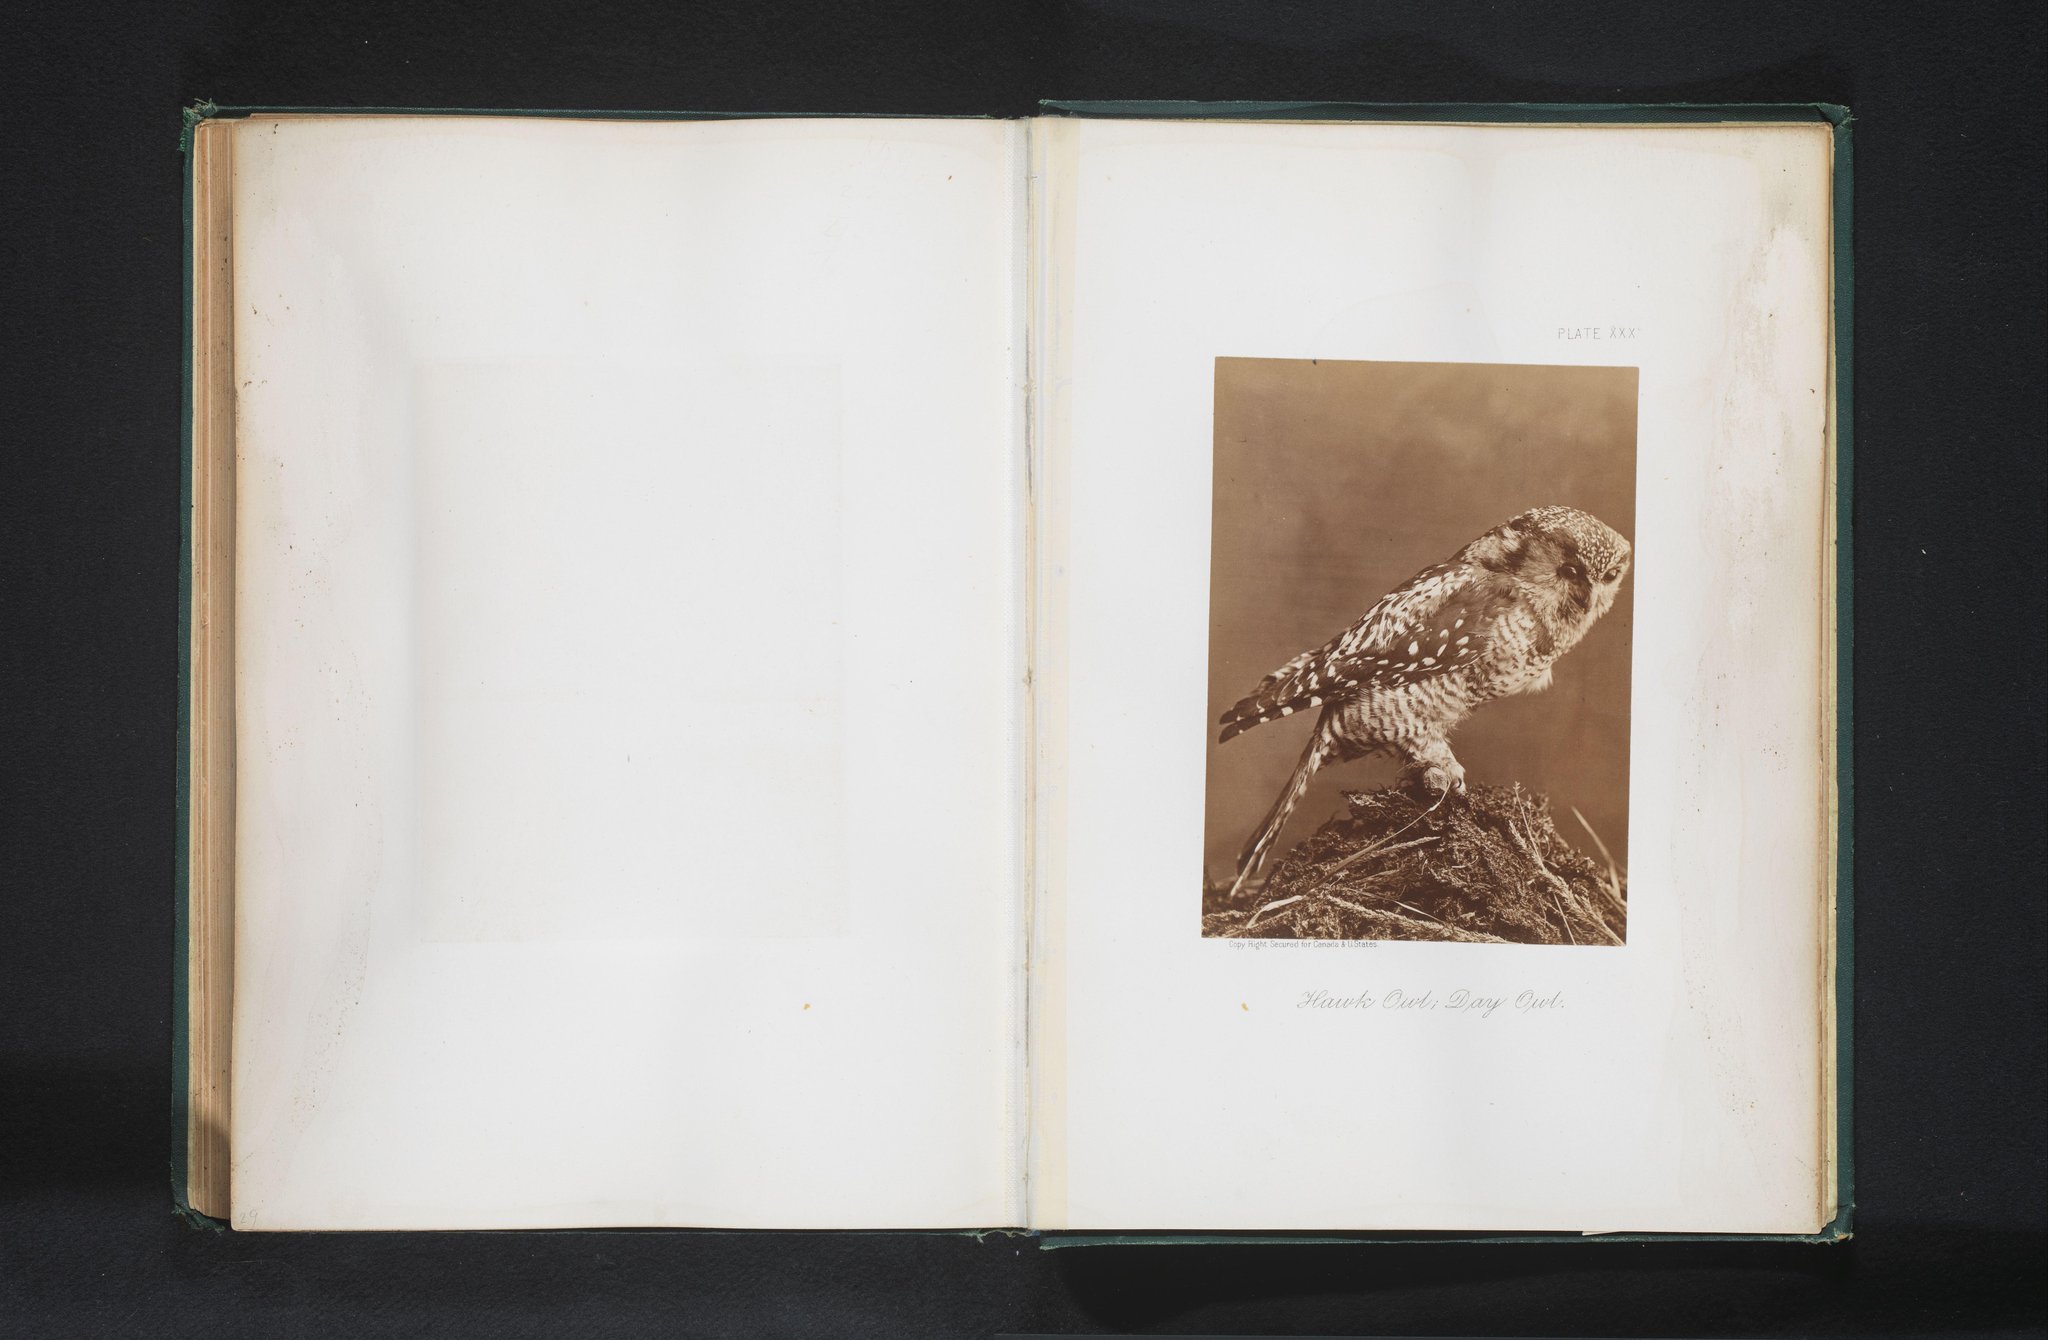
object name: photograph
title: Hawk Owl; Day Out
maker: william notman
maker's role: fotograaf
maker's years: 1826-1891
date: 1871-1876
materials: paper, photographic support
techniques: albumen print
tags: collection of animals, owls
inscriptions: number: ‘PLATE XXX’, inscription: ‘Copy Right Secured for Canada & U.States’